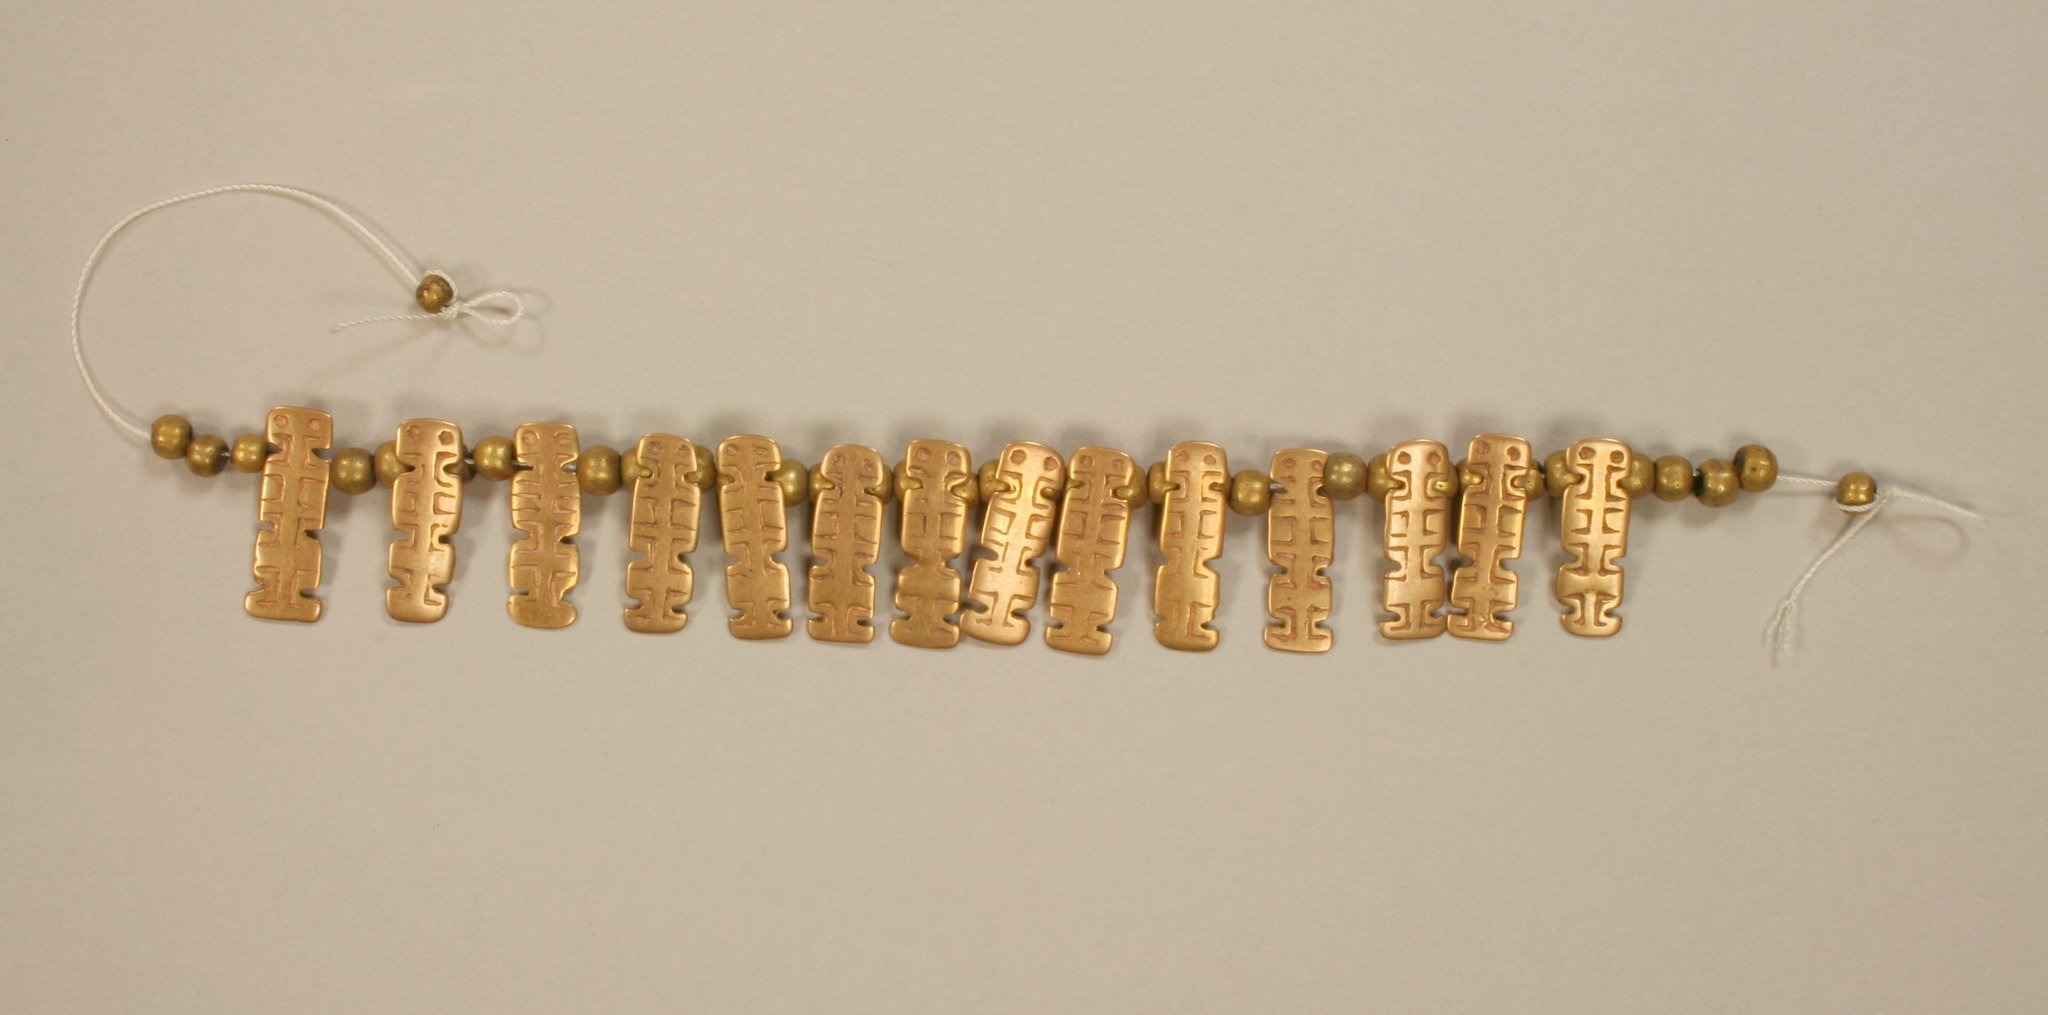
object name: necklace ornament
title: Necklace Ornaments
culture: tolima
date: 401-1000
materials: gold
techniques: casting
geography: colombia